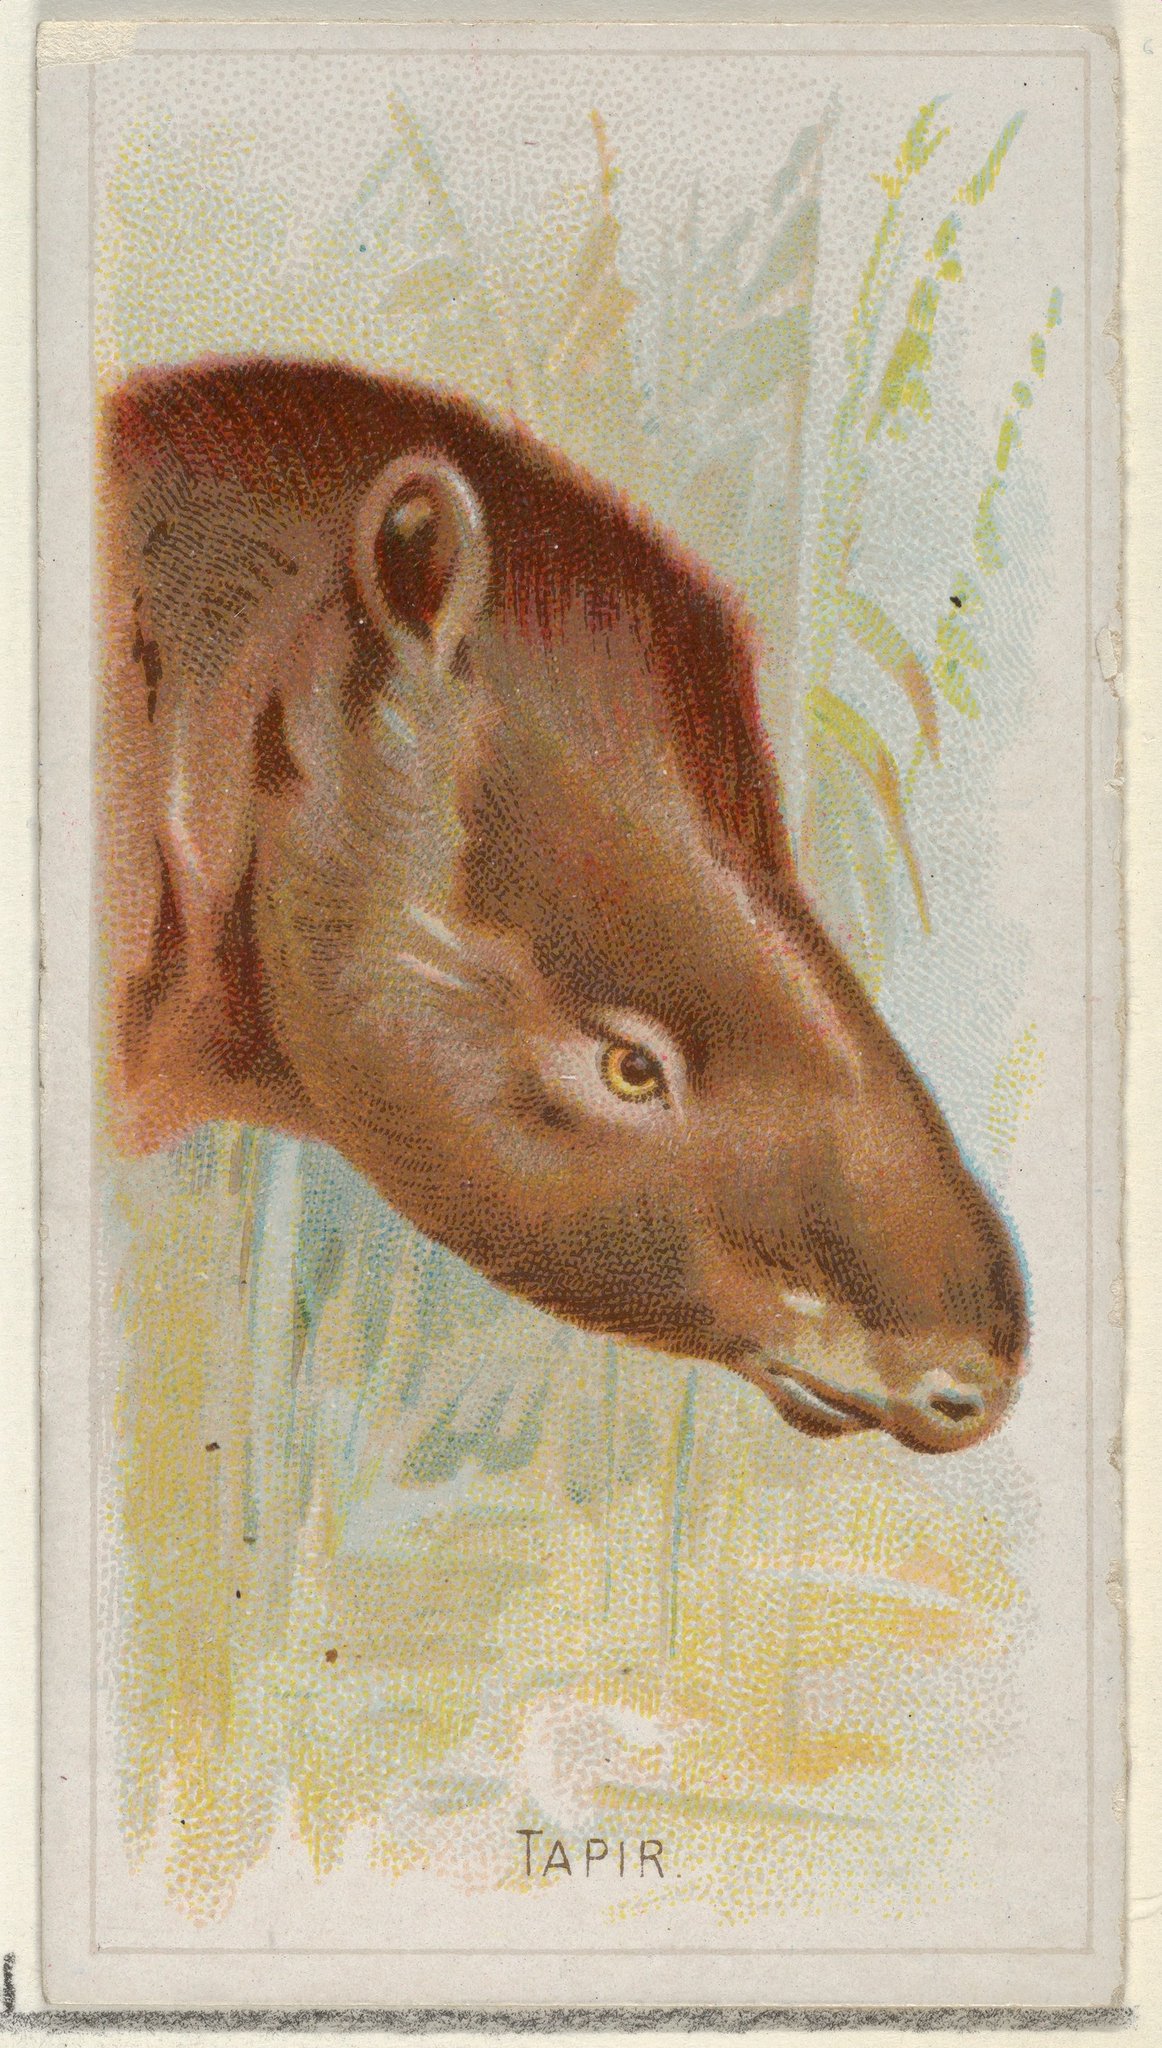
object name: print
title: Tapir, from the Wild Animals of the World series (N25) for Allen & Ginter Cigarettes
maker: allen & ginter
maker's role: publisher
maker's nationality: american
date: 1888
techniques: color lithograph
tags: animals